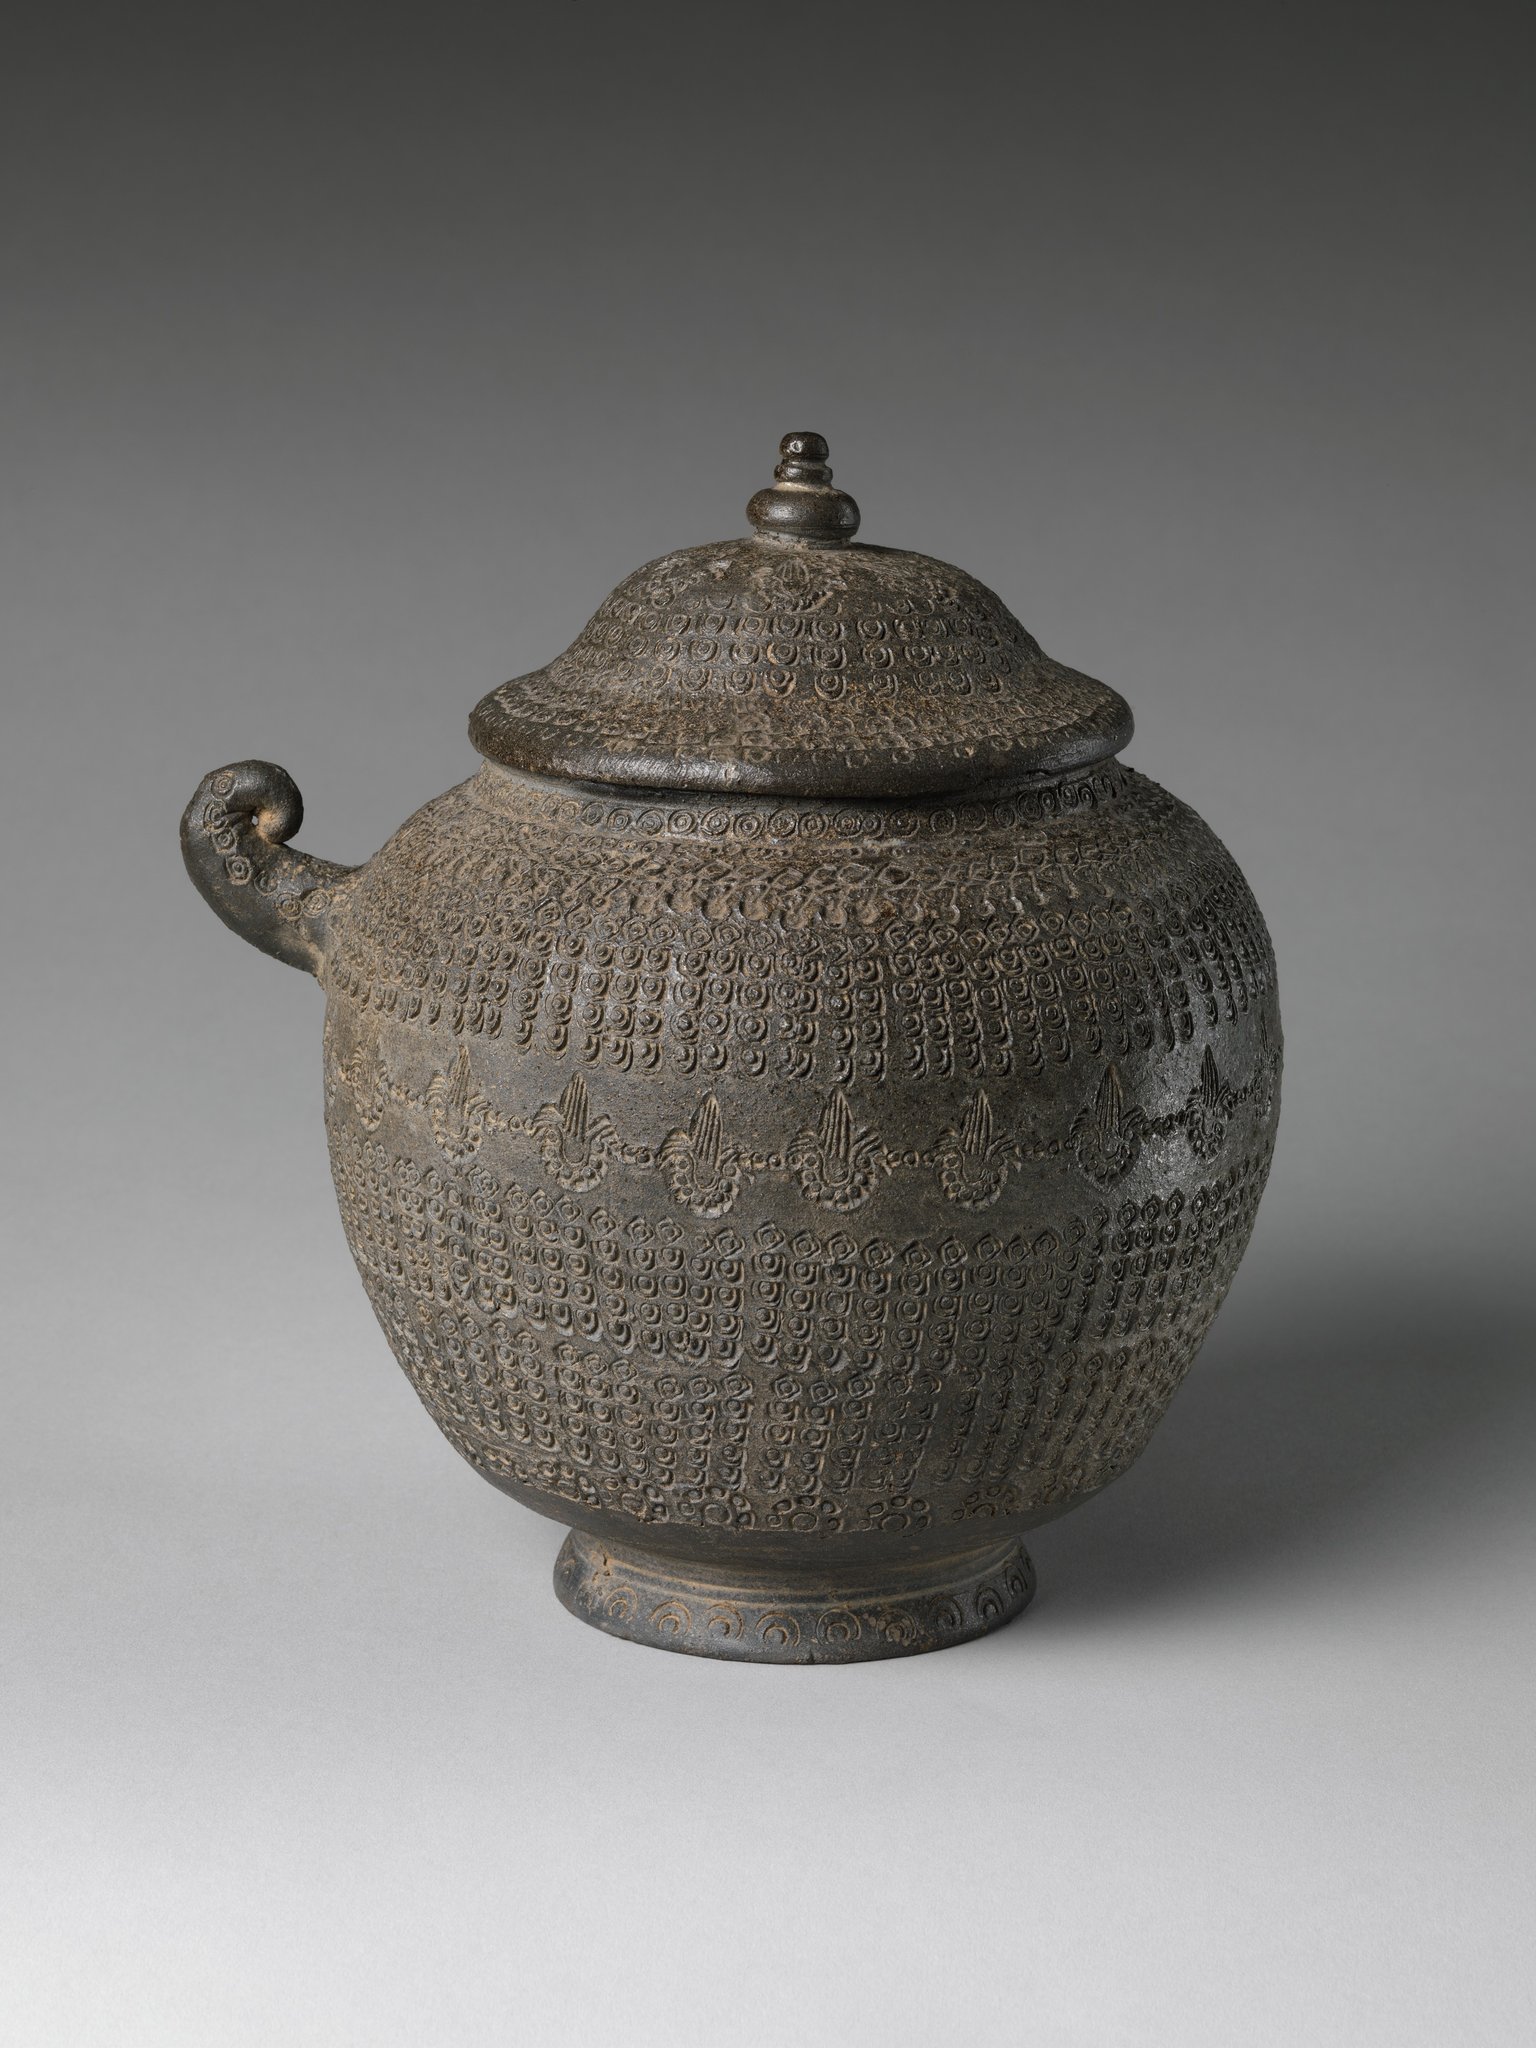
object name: urn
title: Covered urn with geometric decoration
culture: korean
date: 701-800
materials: stoneware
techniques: stamping